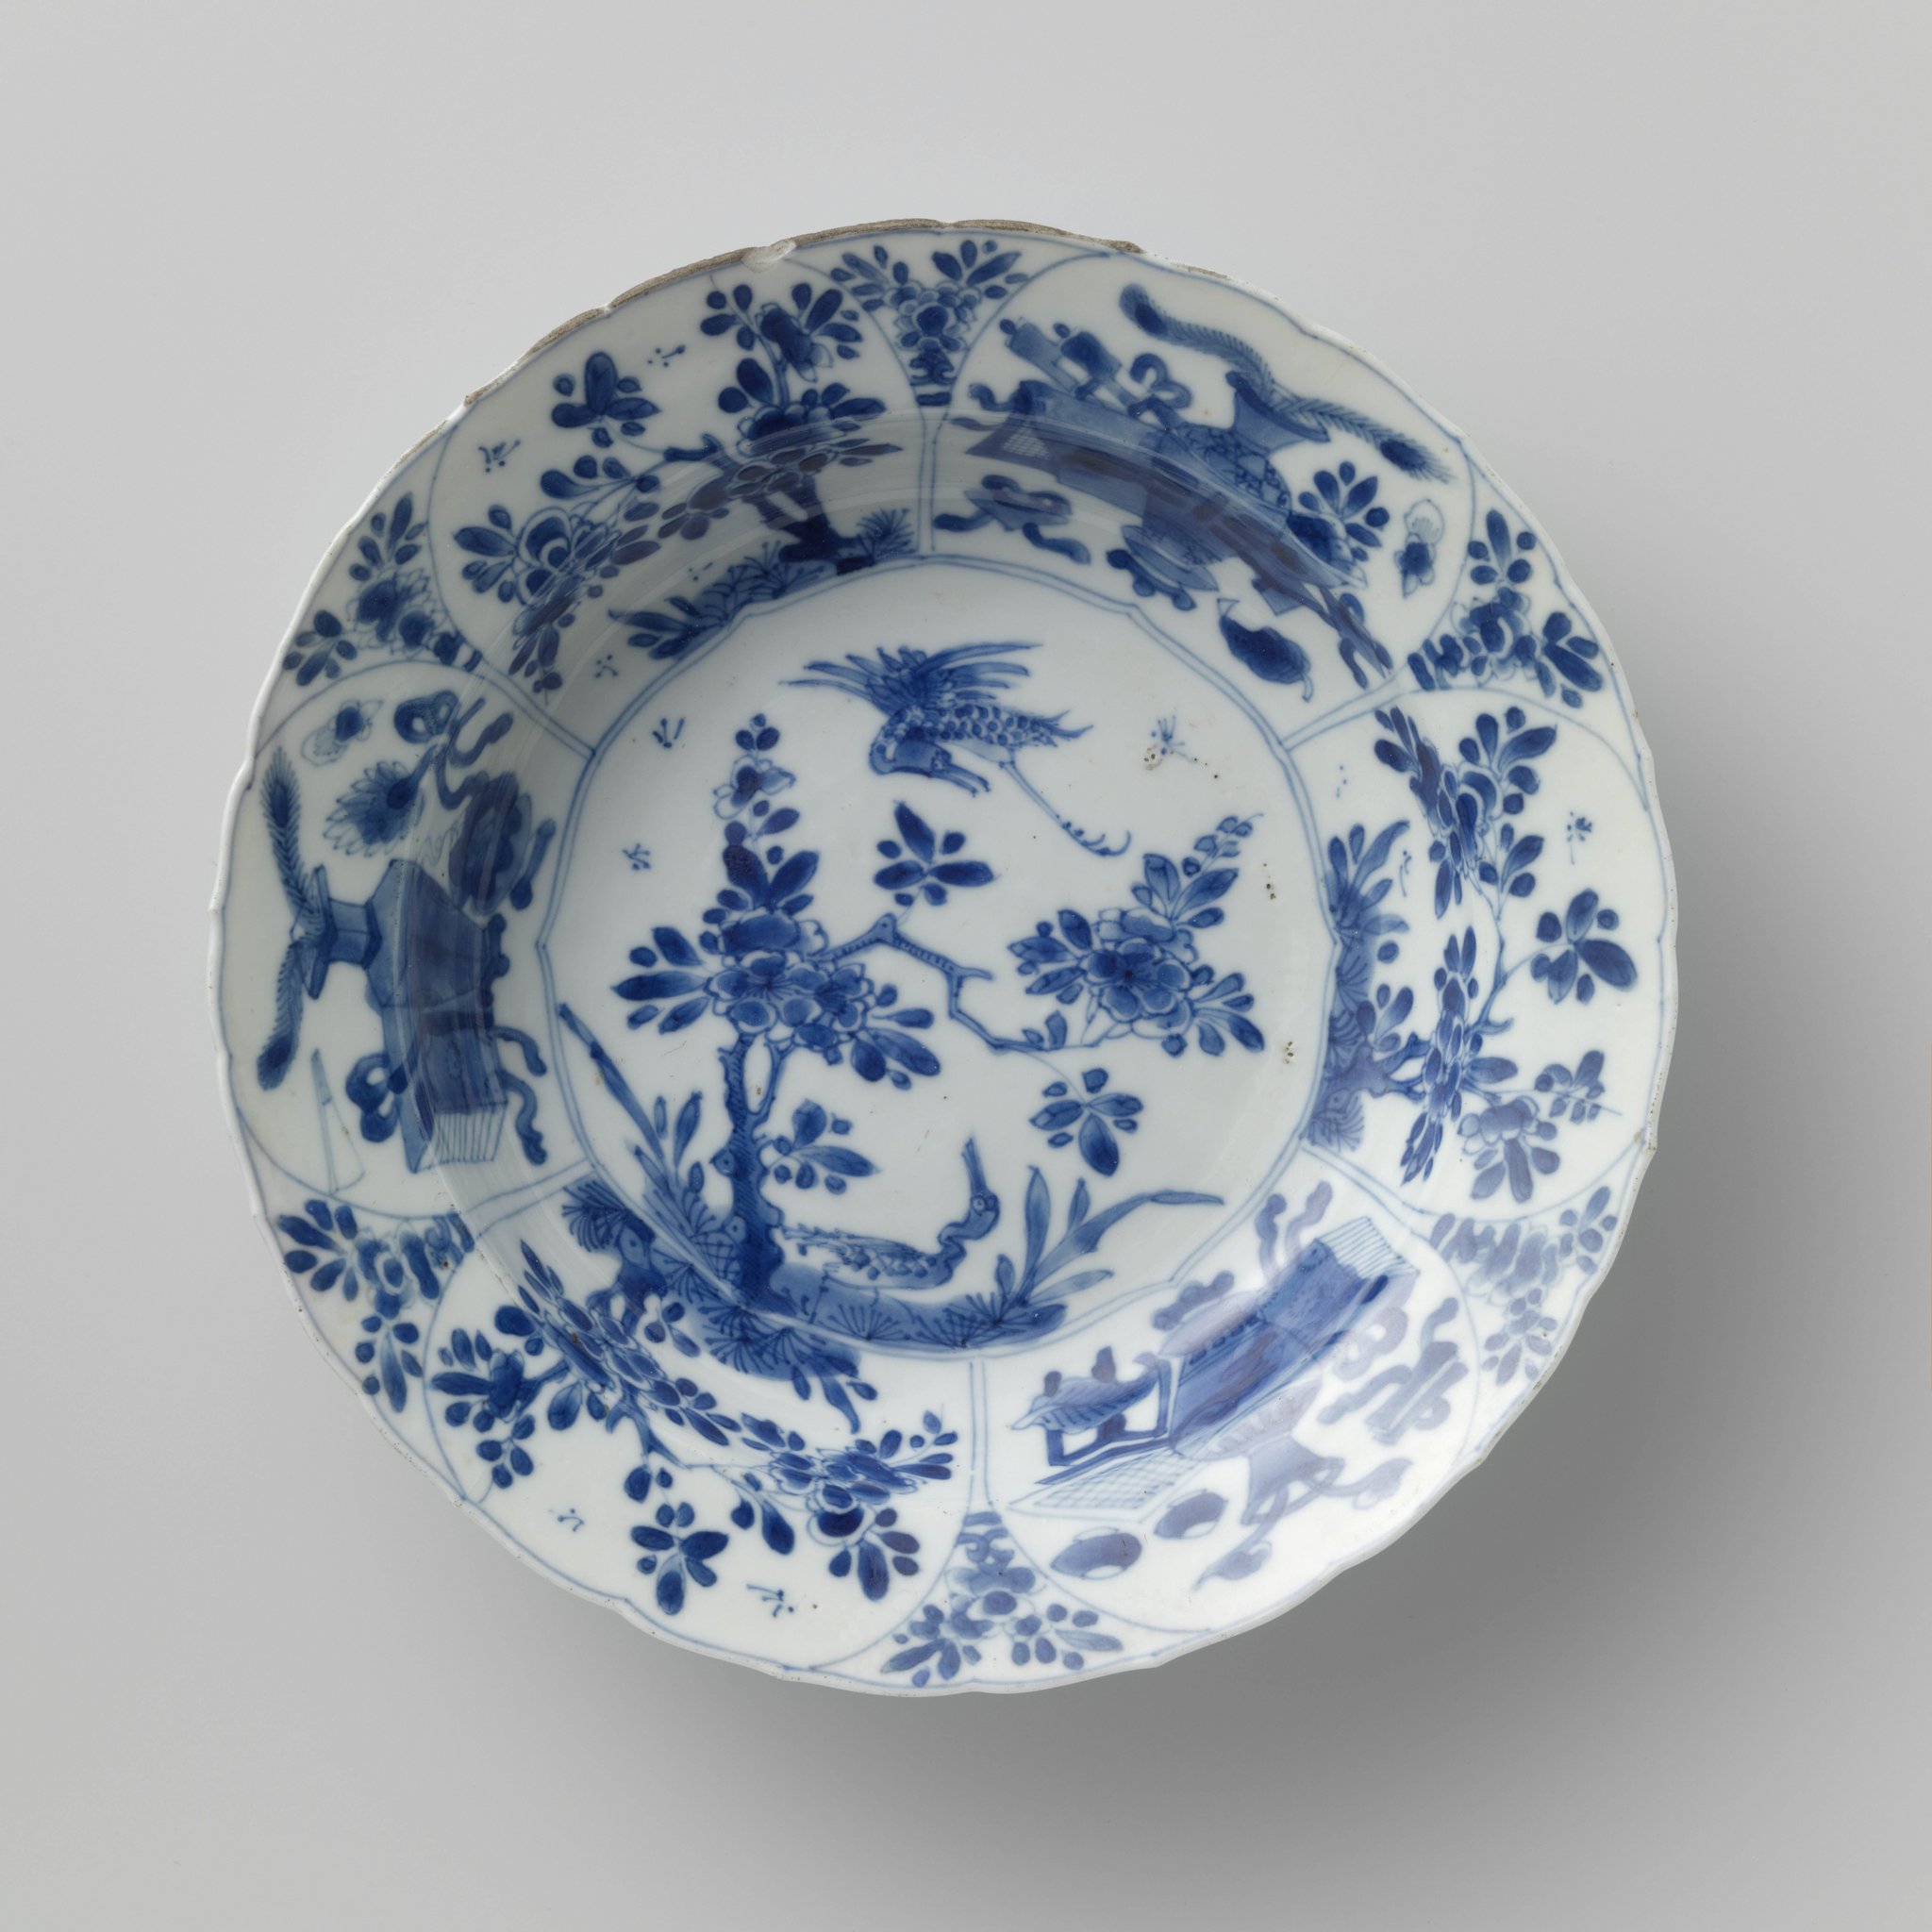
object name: platter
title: Deep dish with cranes, prunus trees and antiquities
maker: Anonymous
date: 1680-1720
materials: cobalt, glaze, paint, porcelain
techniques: firing, turning, vitrification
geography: china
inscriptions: mark: ‘玉 Yù’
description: Bord, accoladevormig geschulpte rand, op plat een staande en een vliegende reiger bij een bloeiende struik.